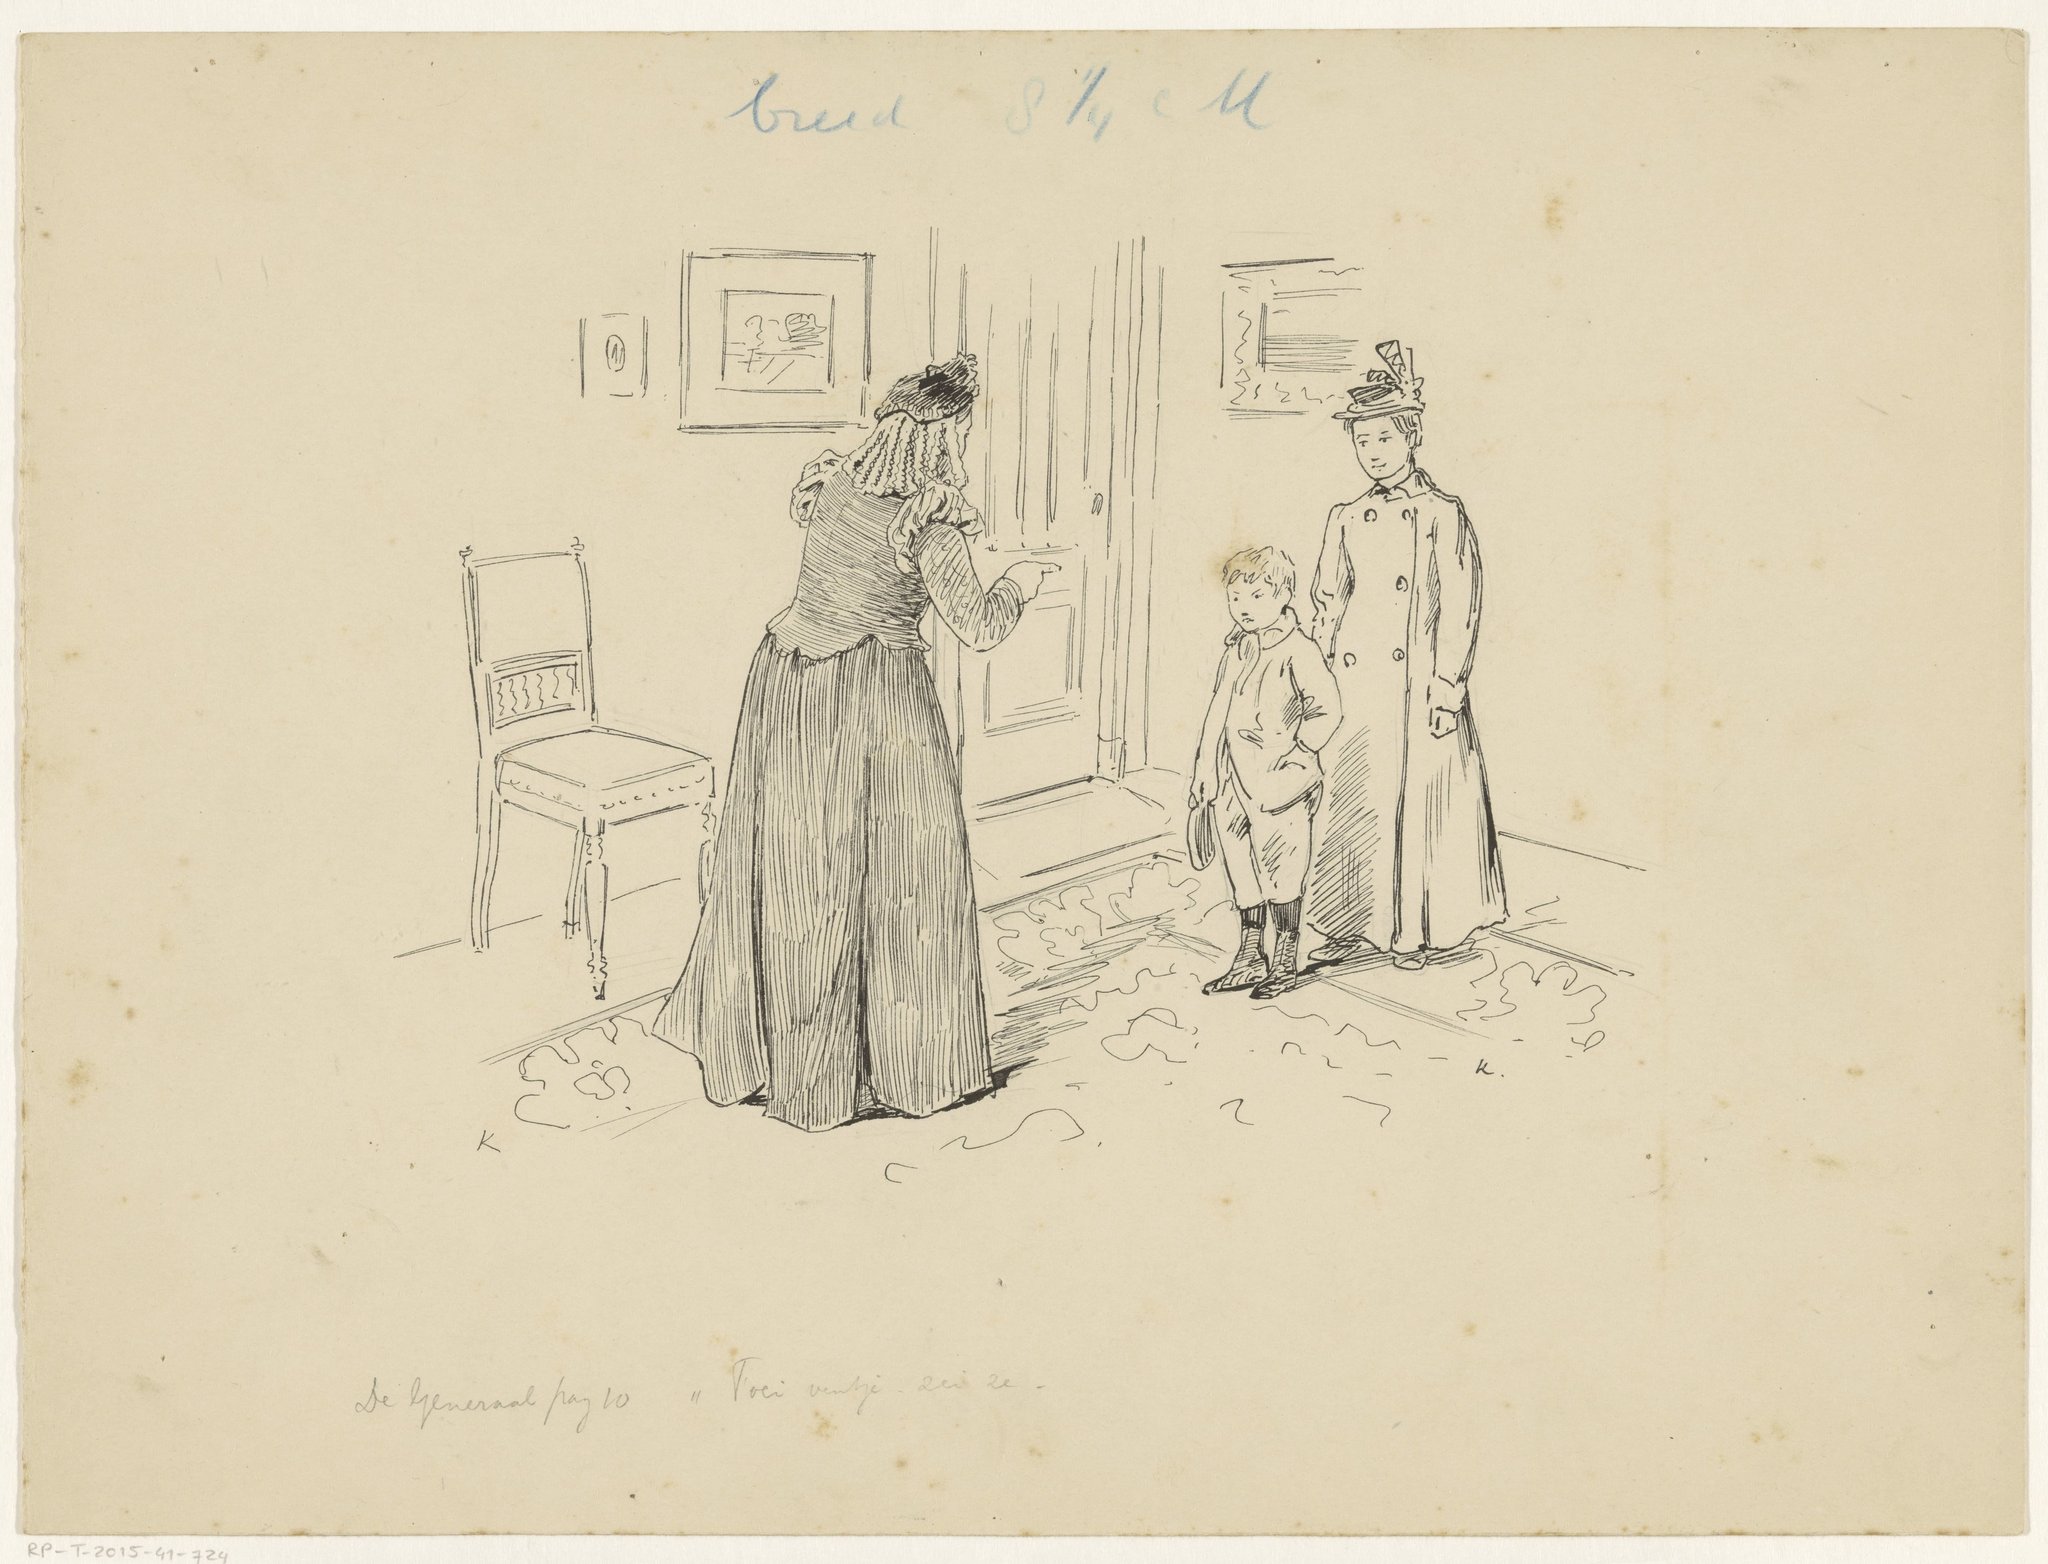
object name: boekillustratie ontwerp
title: Jongen wordt terechtgewezen door een vrouw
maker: heinrich m. krabbé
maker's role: draughtsman, print maker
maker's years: 1868-1931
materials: ink, paper, pencil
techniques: pen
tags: boy (child between toddler and youth), interior of the house, index finger forwards, pointing, indicating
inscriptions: :, collector's mark: Lugt 2228, annotation: ‘De Generaal pag 10 "Foei ventje, zei ze.’, signature: ‘K.’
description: In een interieur staat een jongen voor een jonge vrouw. De twee kijken naar een vrouw die tegenover hen staat en die vermanend haar vinger uitsteekt naar de jongen.